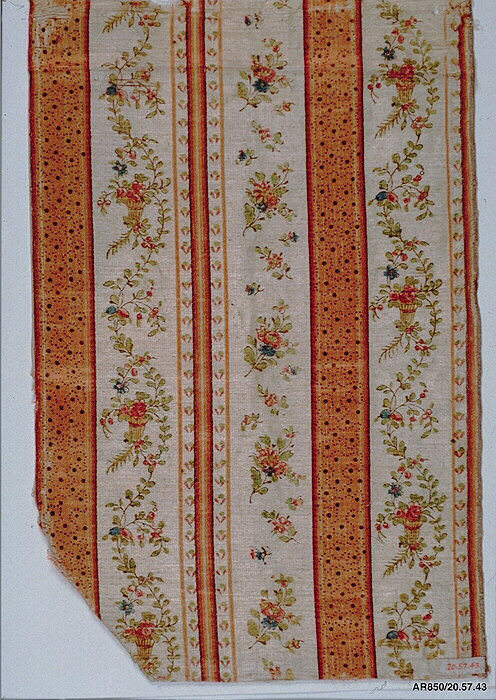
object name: piece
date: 1788-1790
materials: cotton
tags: flowers,leaves